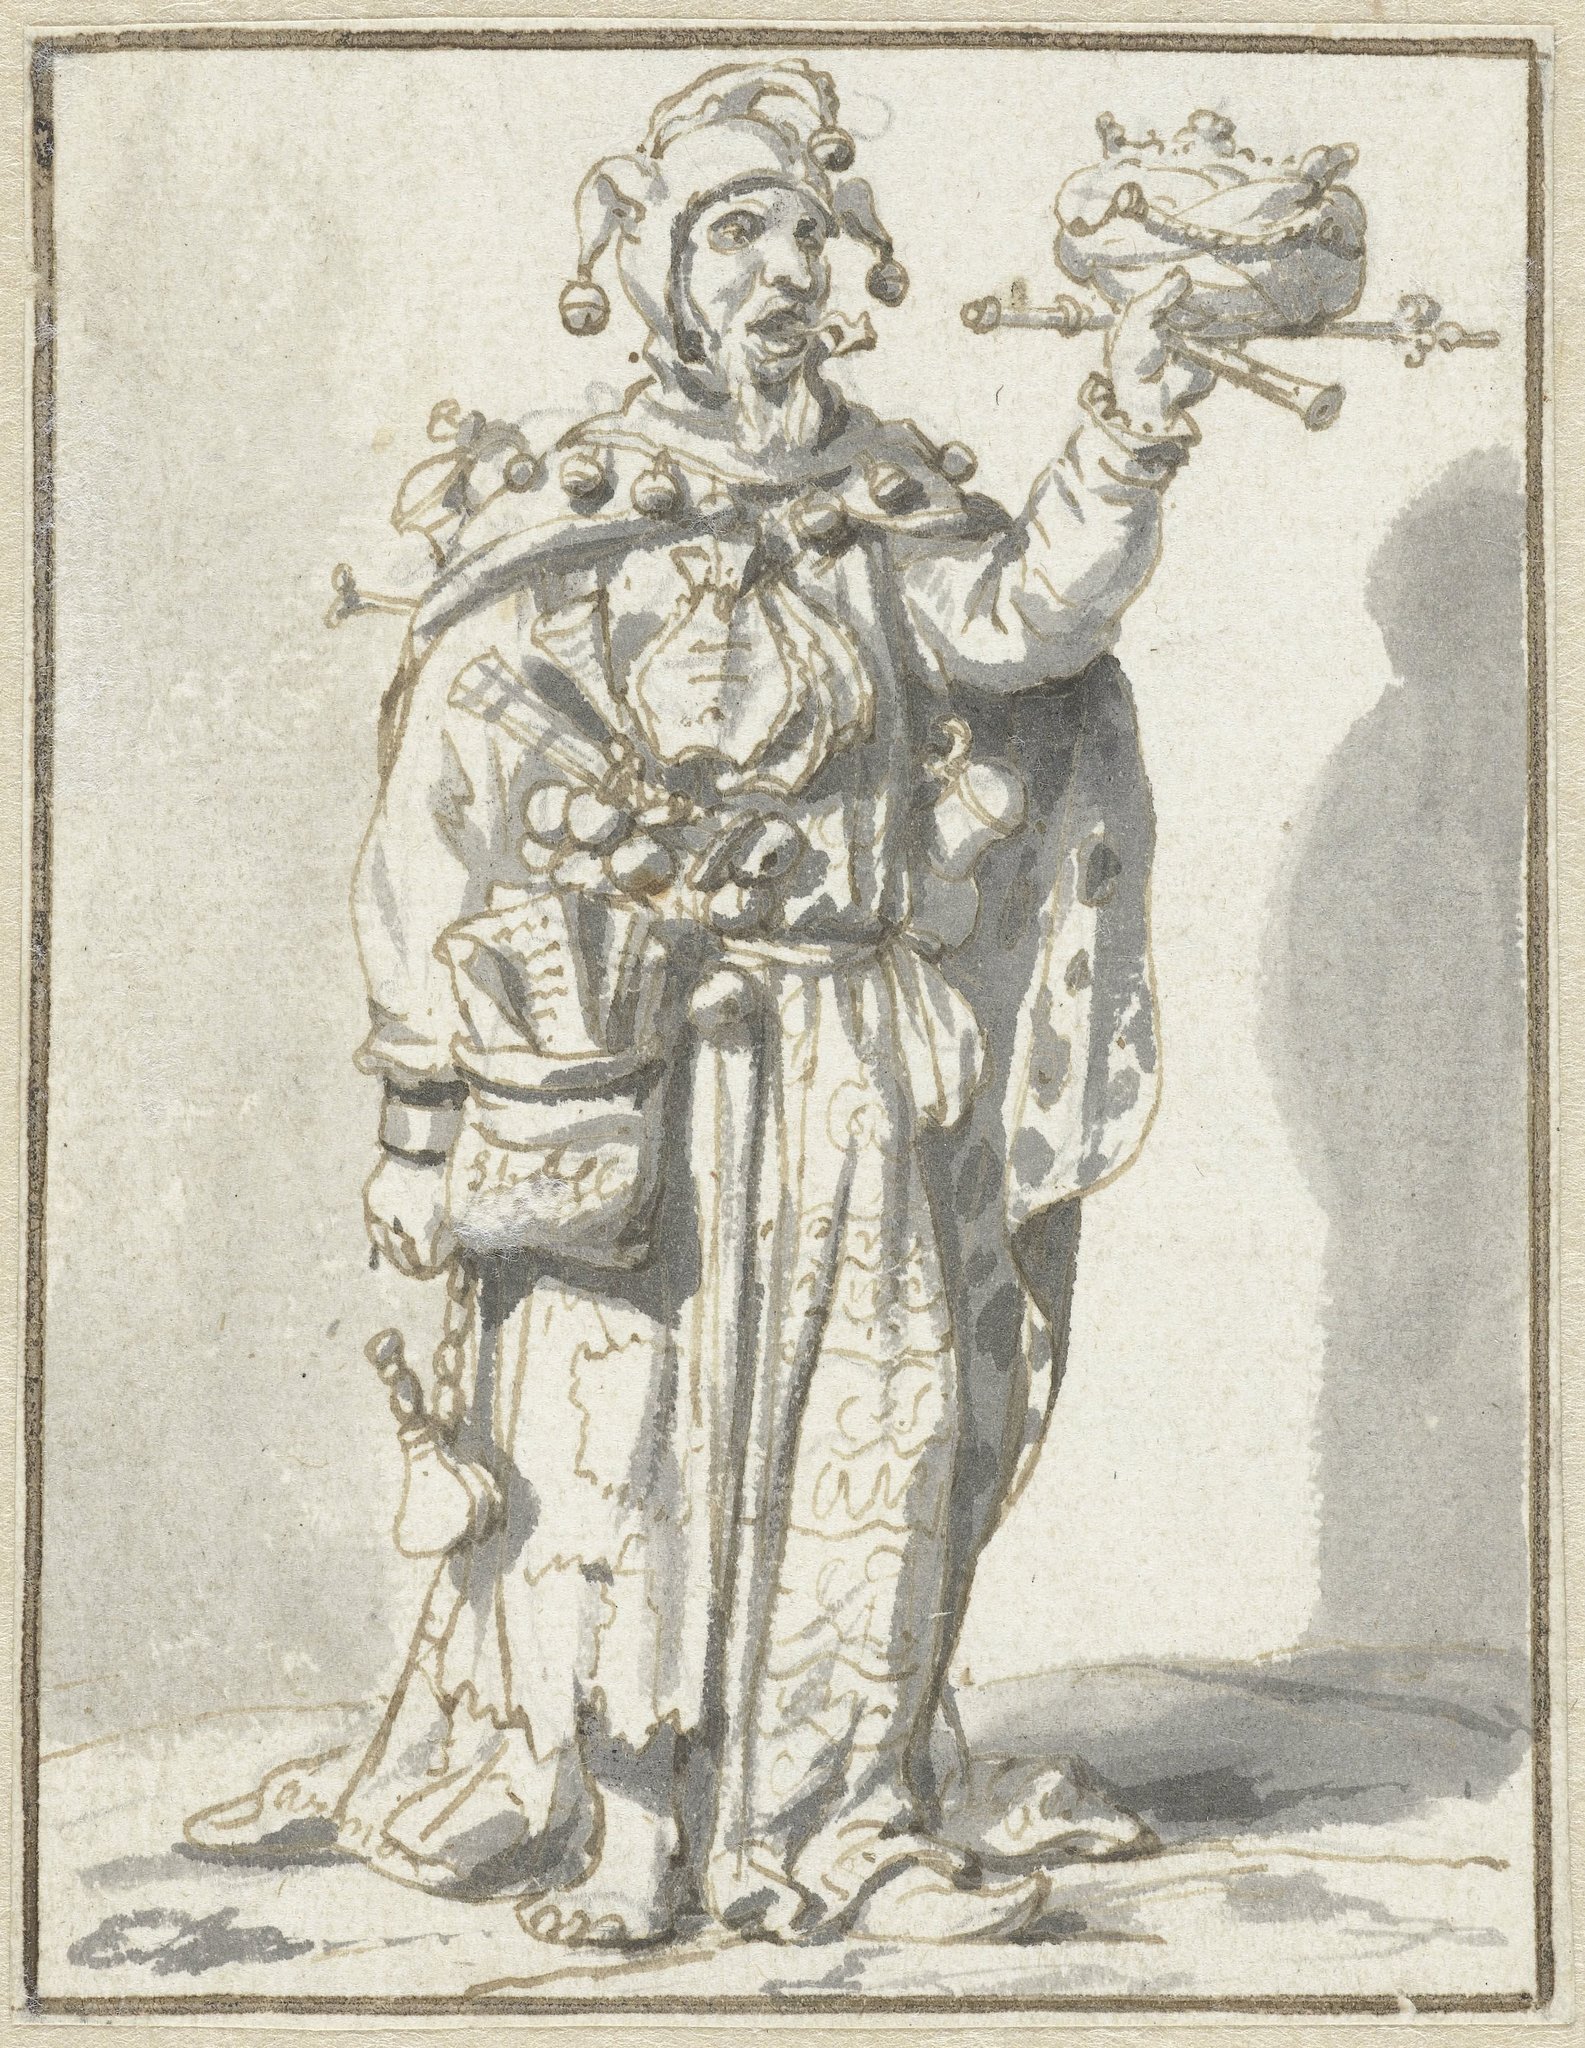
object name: drawing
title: Staande nar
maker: bernard picart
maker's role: draughtsman, print maker, publisher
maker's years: 1673-1733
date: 1683-1733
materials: ink, paper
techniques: brush, pen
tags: court jester, court fool